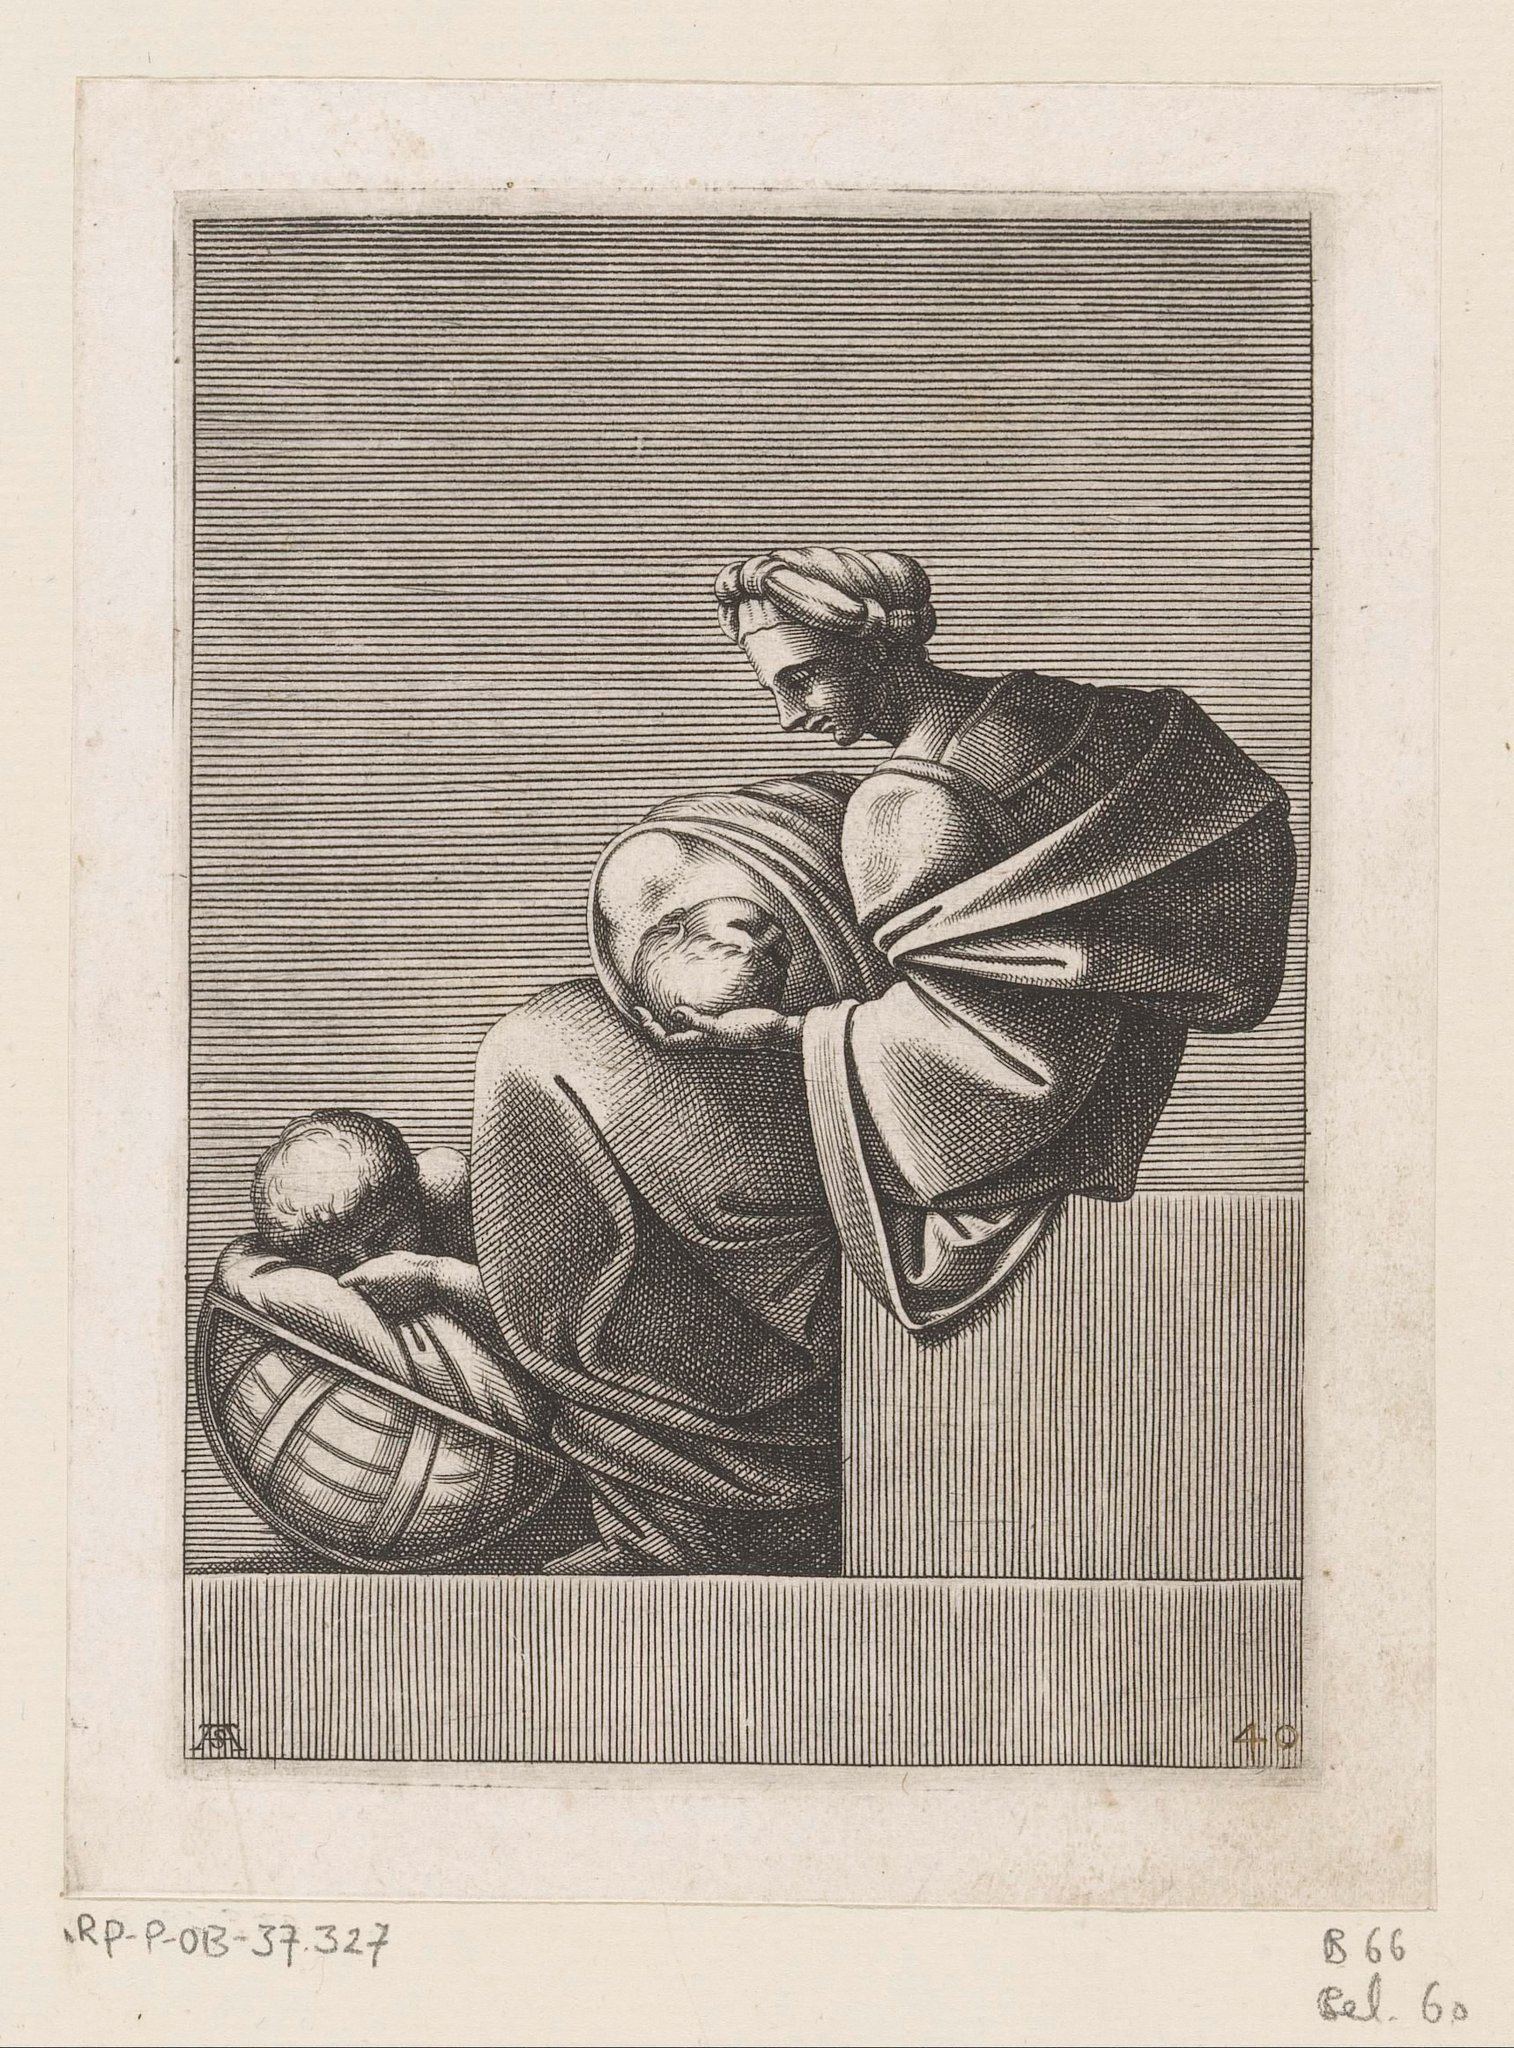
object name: print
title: Zittende vrouw met slapende kinderen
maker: adamo scultori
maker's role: painter, print maker, sculptor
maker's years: 1530-1585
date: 1585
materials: paper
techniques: engraving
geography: vatican city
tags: sleeping; unconsciousness, mother and child(ren), woman and child(ren) (family group)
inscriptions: collector's mark: Lugt 240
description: Deze prent maakt deel uit van een serie bestaande uit een titelprent en 72 prenten naar schilderingen door Michelangelo in de Sixtijnse Kapel in het Vaticaan.